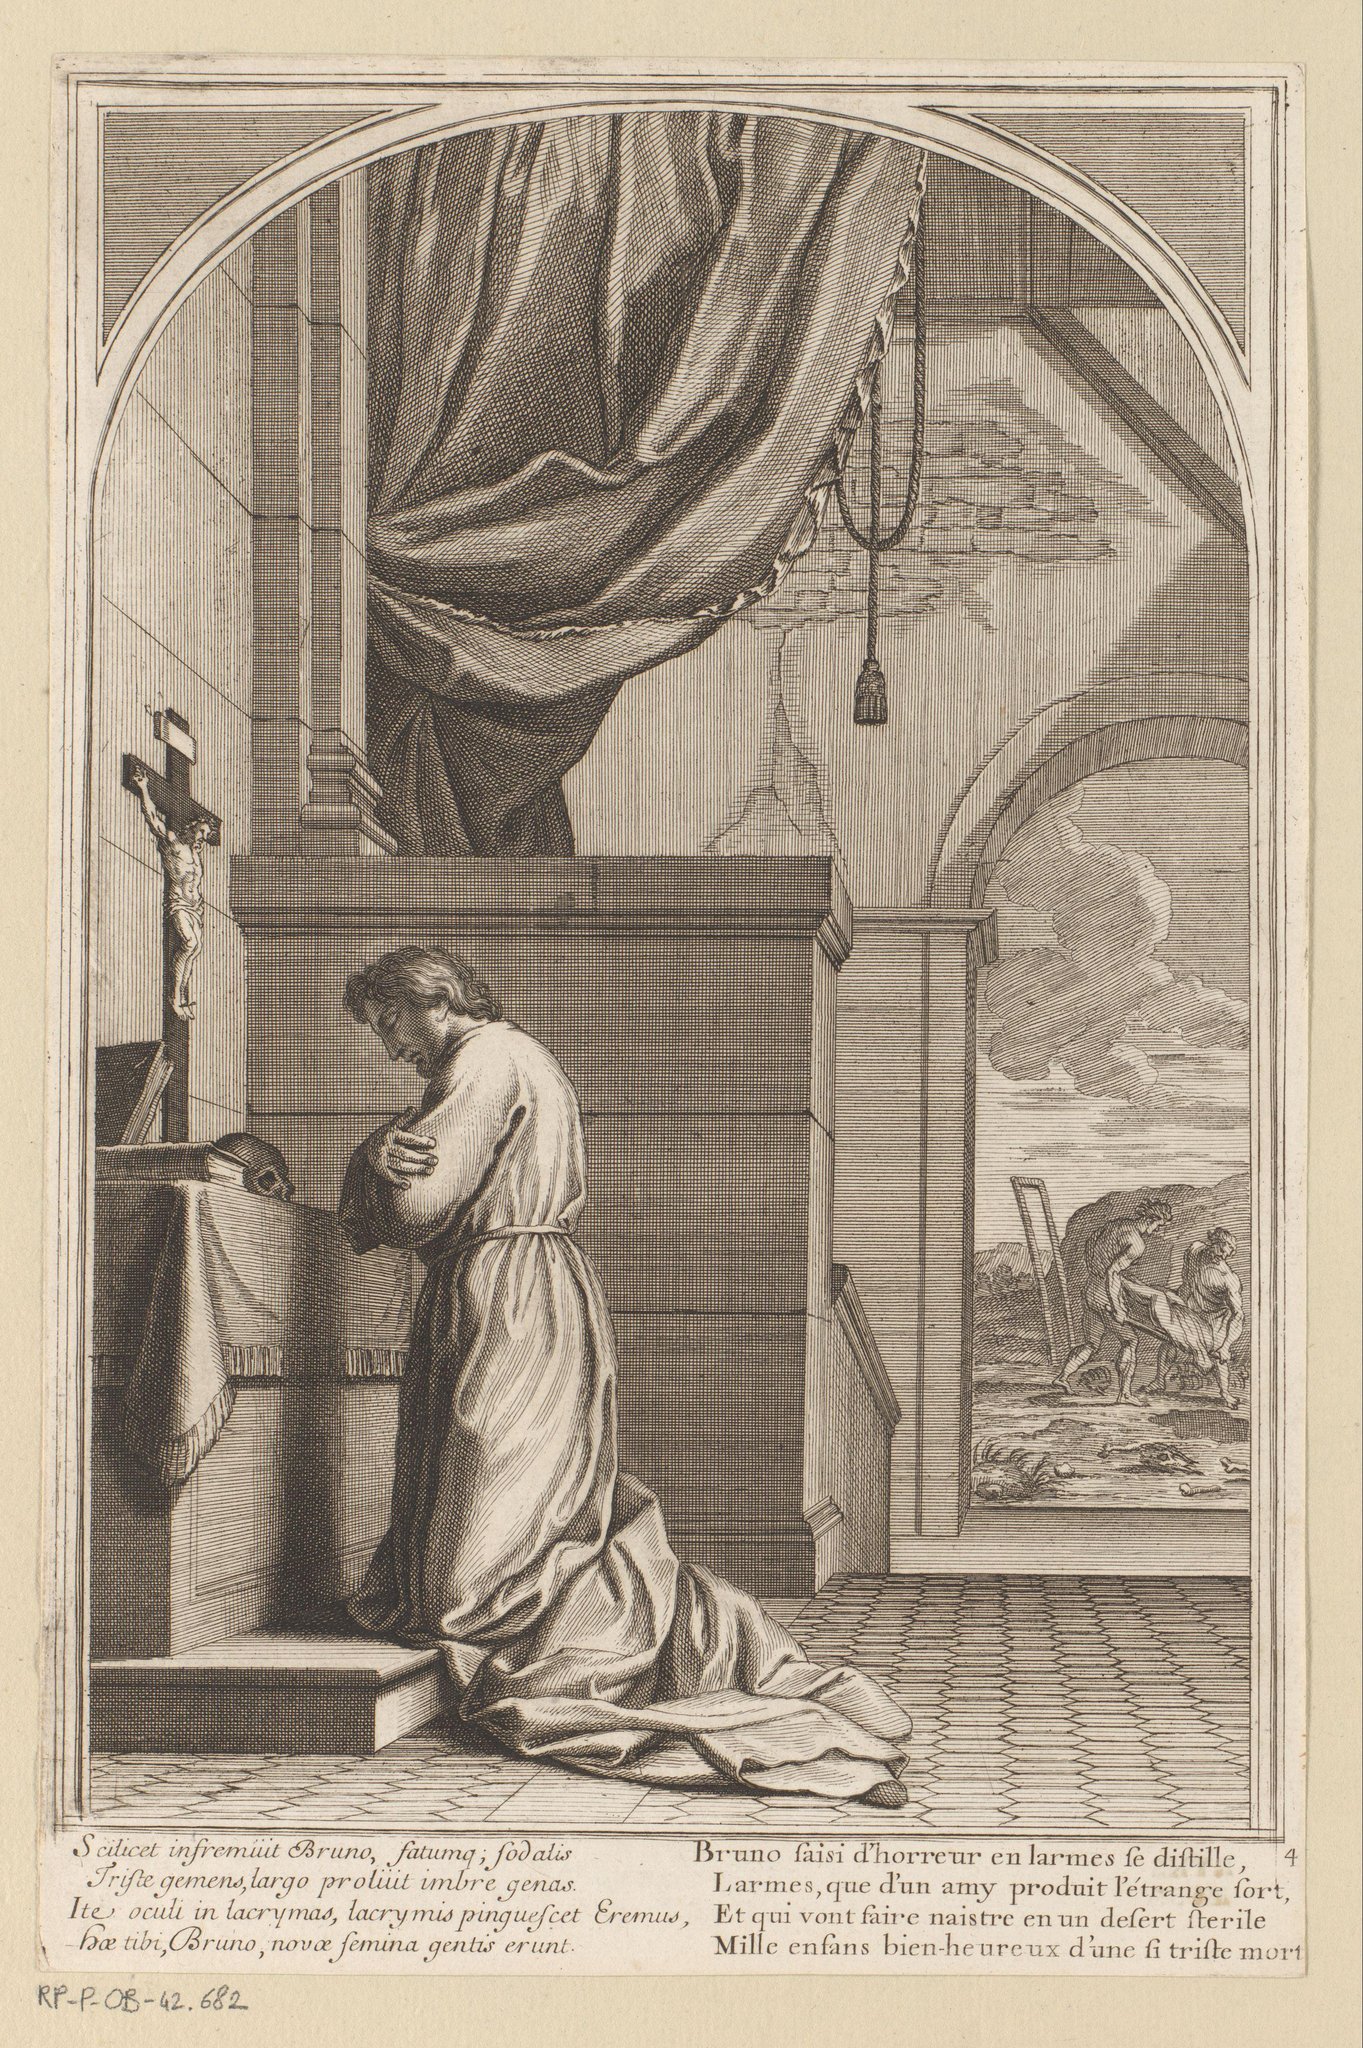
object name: print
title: Heilige Bruno in gebed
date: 1623-1676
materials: paper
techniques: engraving, etching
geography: paris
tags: the founder of the order of the carthusians, bruno; possible attributes: cross, finger at lips, lily, mitre at his feet, olive-branch, ray of light, skull, (seven) star(s), personal devotion of st. bruno - male saint meditating, in ecstasy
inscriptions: collector's mark: Lugt 2165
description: Maakt deel uit van een serie met 24 prenten (inclusief twee titelprenten), naar schilderijen door Lesueur vervaardigd tussen 1645-1648 voor de Chartreuse de Paris. De serie is getiteld: La vie de St. Bruno fondateur de l'Ordre des Chartreux peinte au cloistre de la Chartreuse de Paris par Eustache Le Sueur.